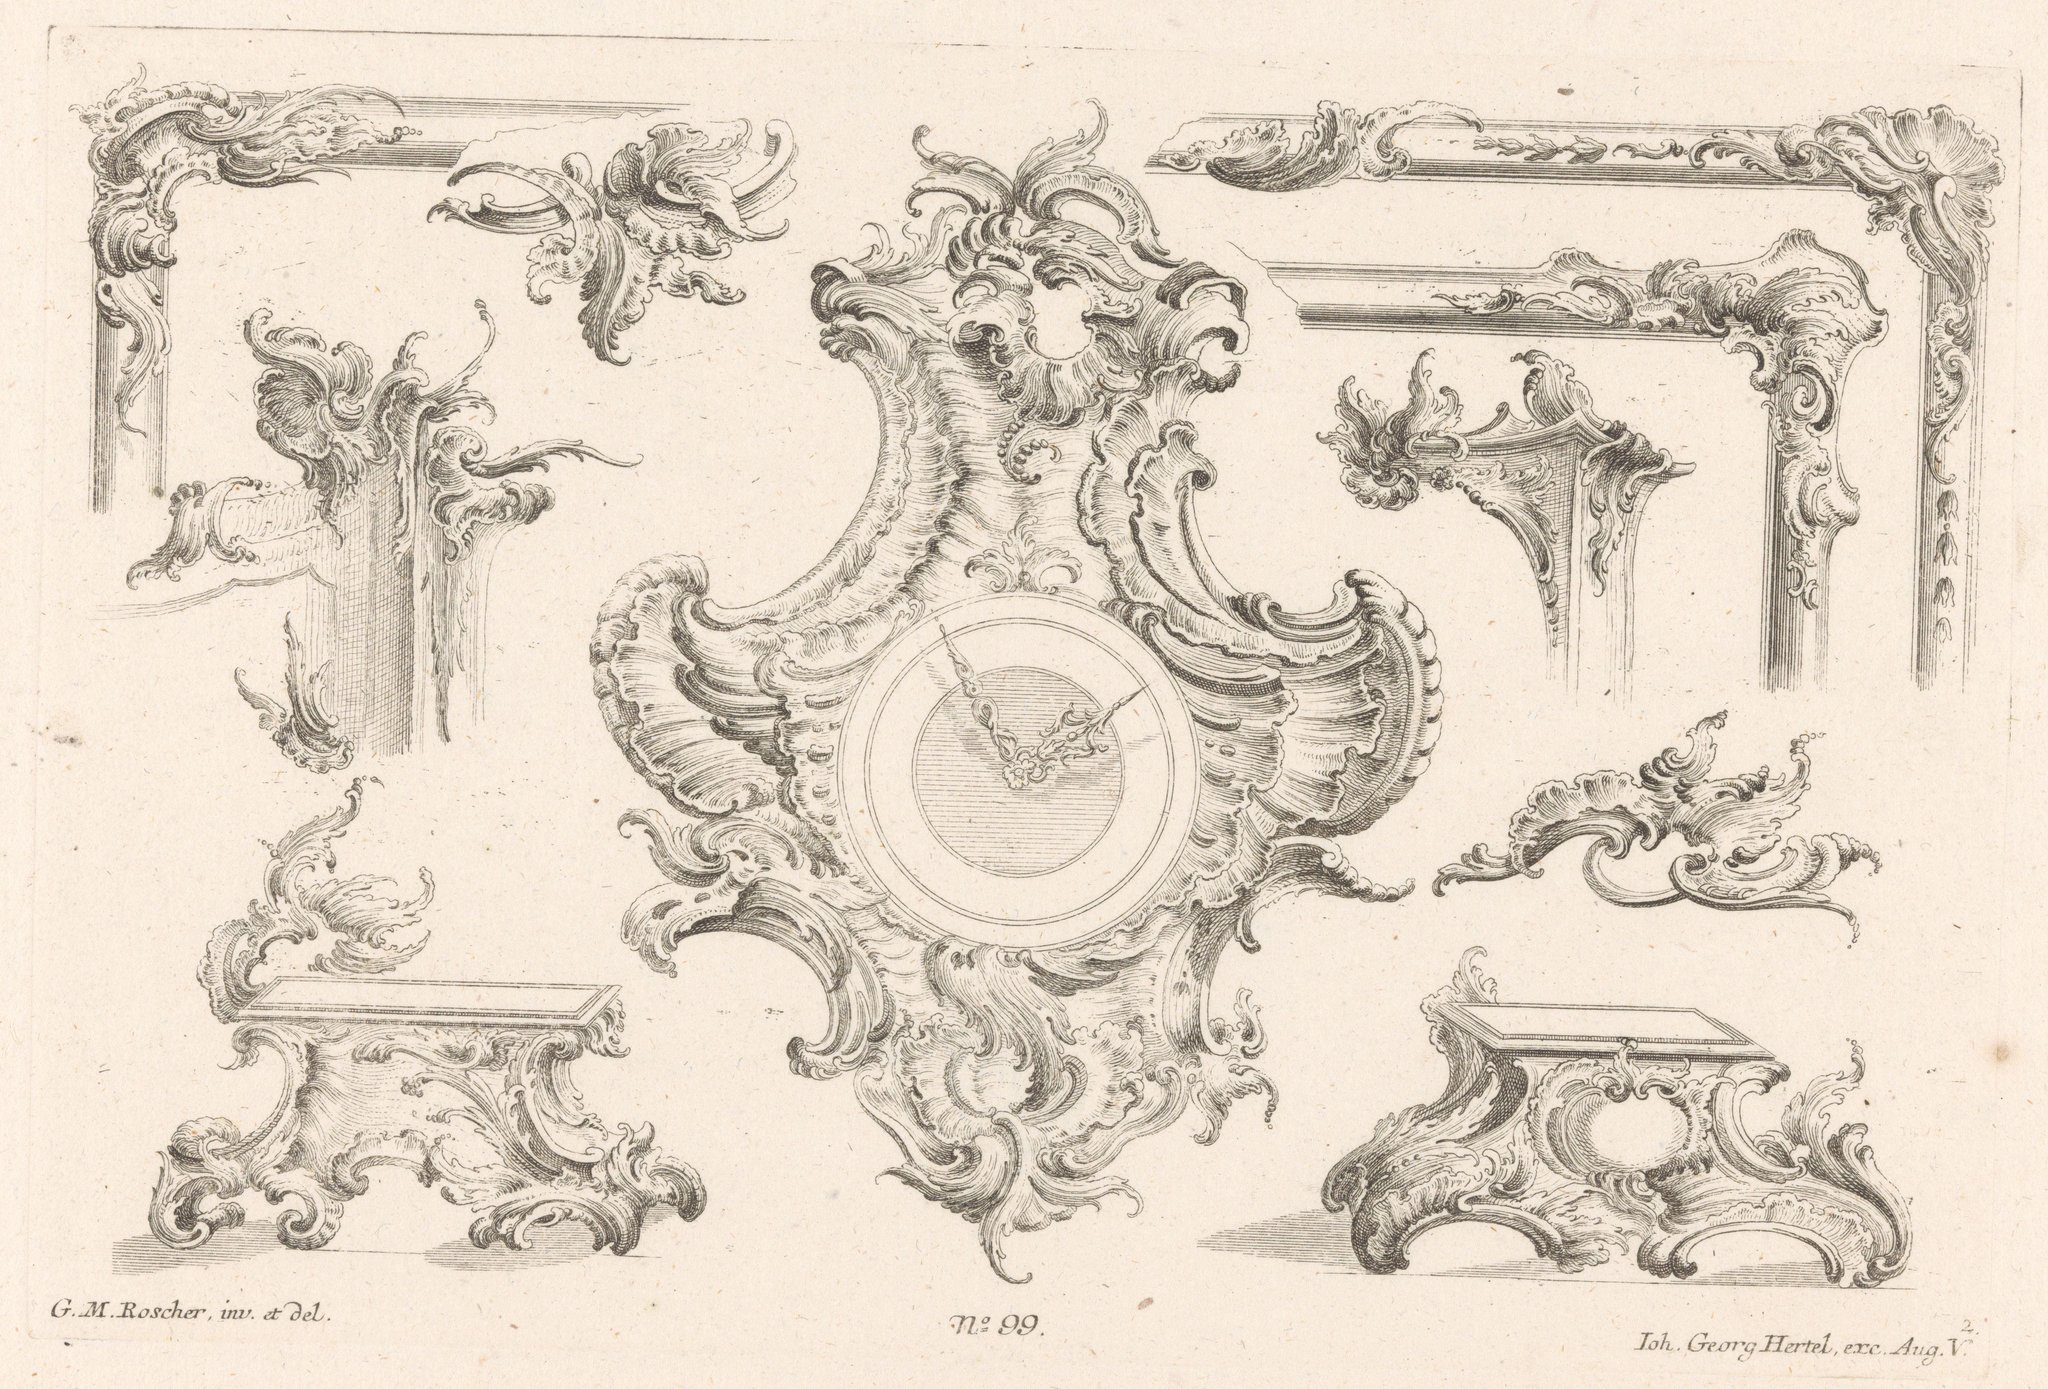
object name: ornament print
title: Klok en tafels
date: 1705-1775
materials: paper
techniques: etching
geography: augsburg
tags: rocaille ornament, ornaments ~ art (+ framing decorations), table, clock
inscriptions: collector's mark: Lugt 2228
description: Rocaille ornamenten, spiegellijsten en klok en twee tafels met rocaille onderstel. Uitgeversnummer 99.